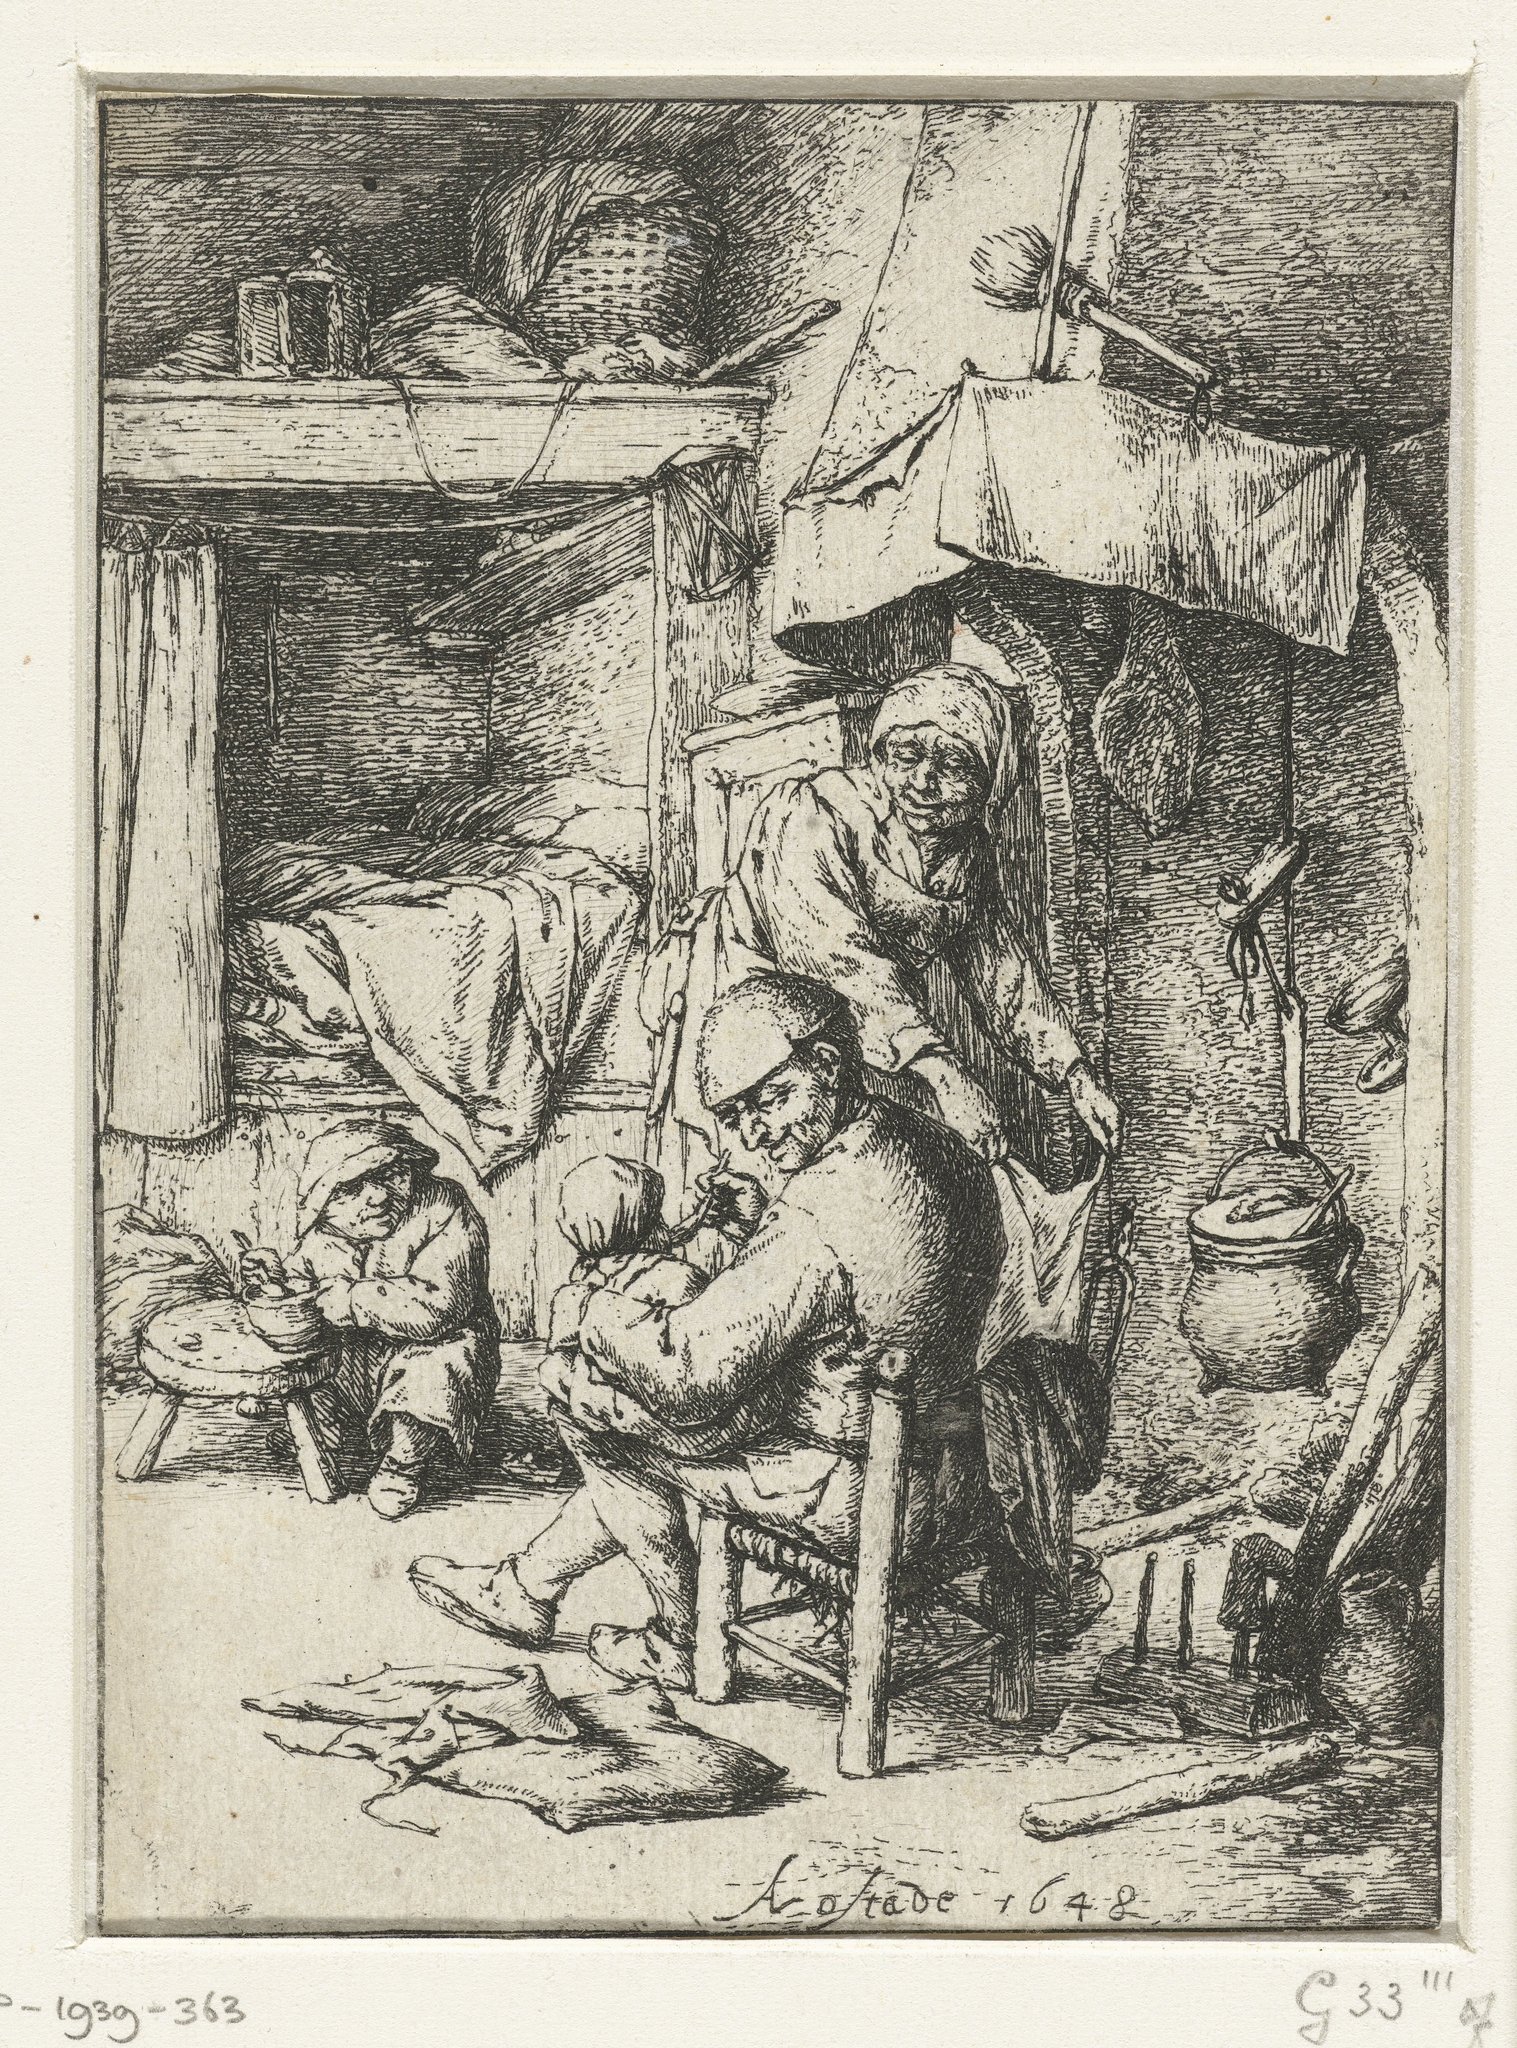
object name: print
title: Vader met kind op schoot in interieur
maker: adriaen van ostade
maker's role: draughtsman, painter, print maker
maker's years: 1610-1685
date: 1648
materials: paper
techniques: drypoint, etching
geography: haarlem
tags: (family) meal, father and child(ren), man and child(ren) (family group)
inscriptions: collector's mark: Lugt 2133, collector's mark: Lugt 2228a, collector's mark: Lugt 2760, collector's mark: Lugt 1063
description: Een vader geeft een klein kind op zijn schoot te eten, de moeder staat bij de haard waar een pot boven het vuur hangt. Een klein kind zit op de grond bij een kruk te eten. Dit boeren gezin is gesitueerd in een armoedig interieur met verschillende huishoudelijke attributen en op de achtergrond een bedstee.